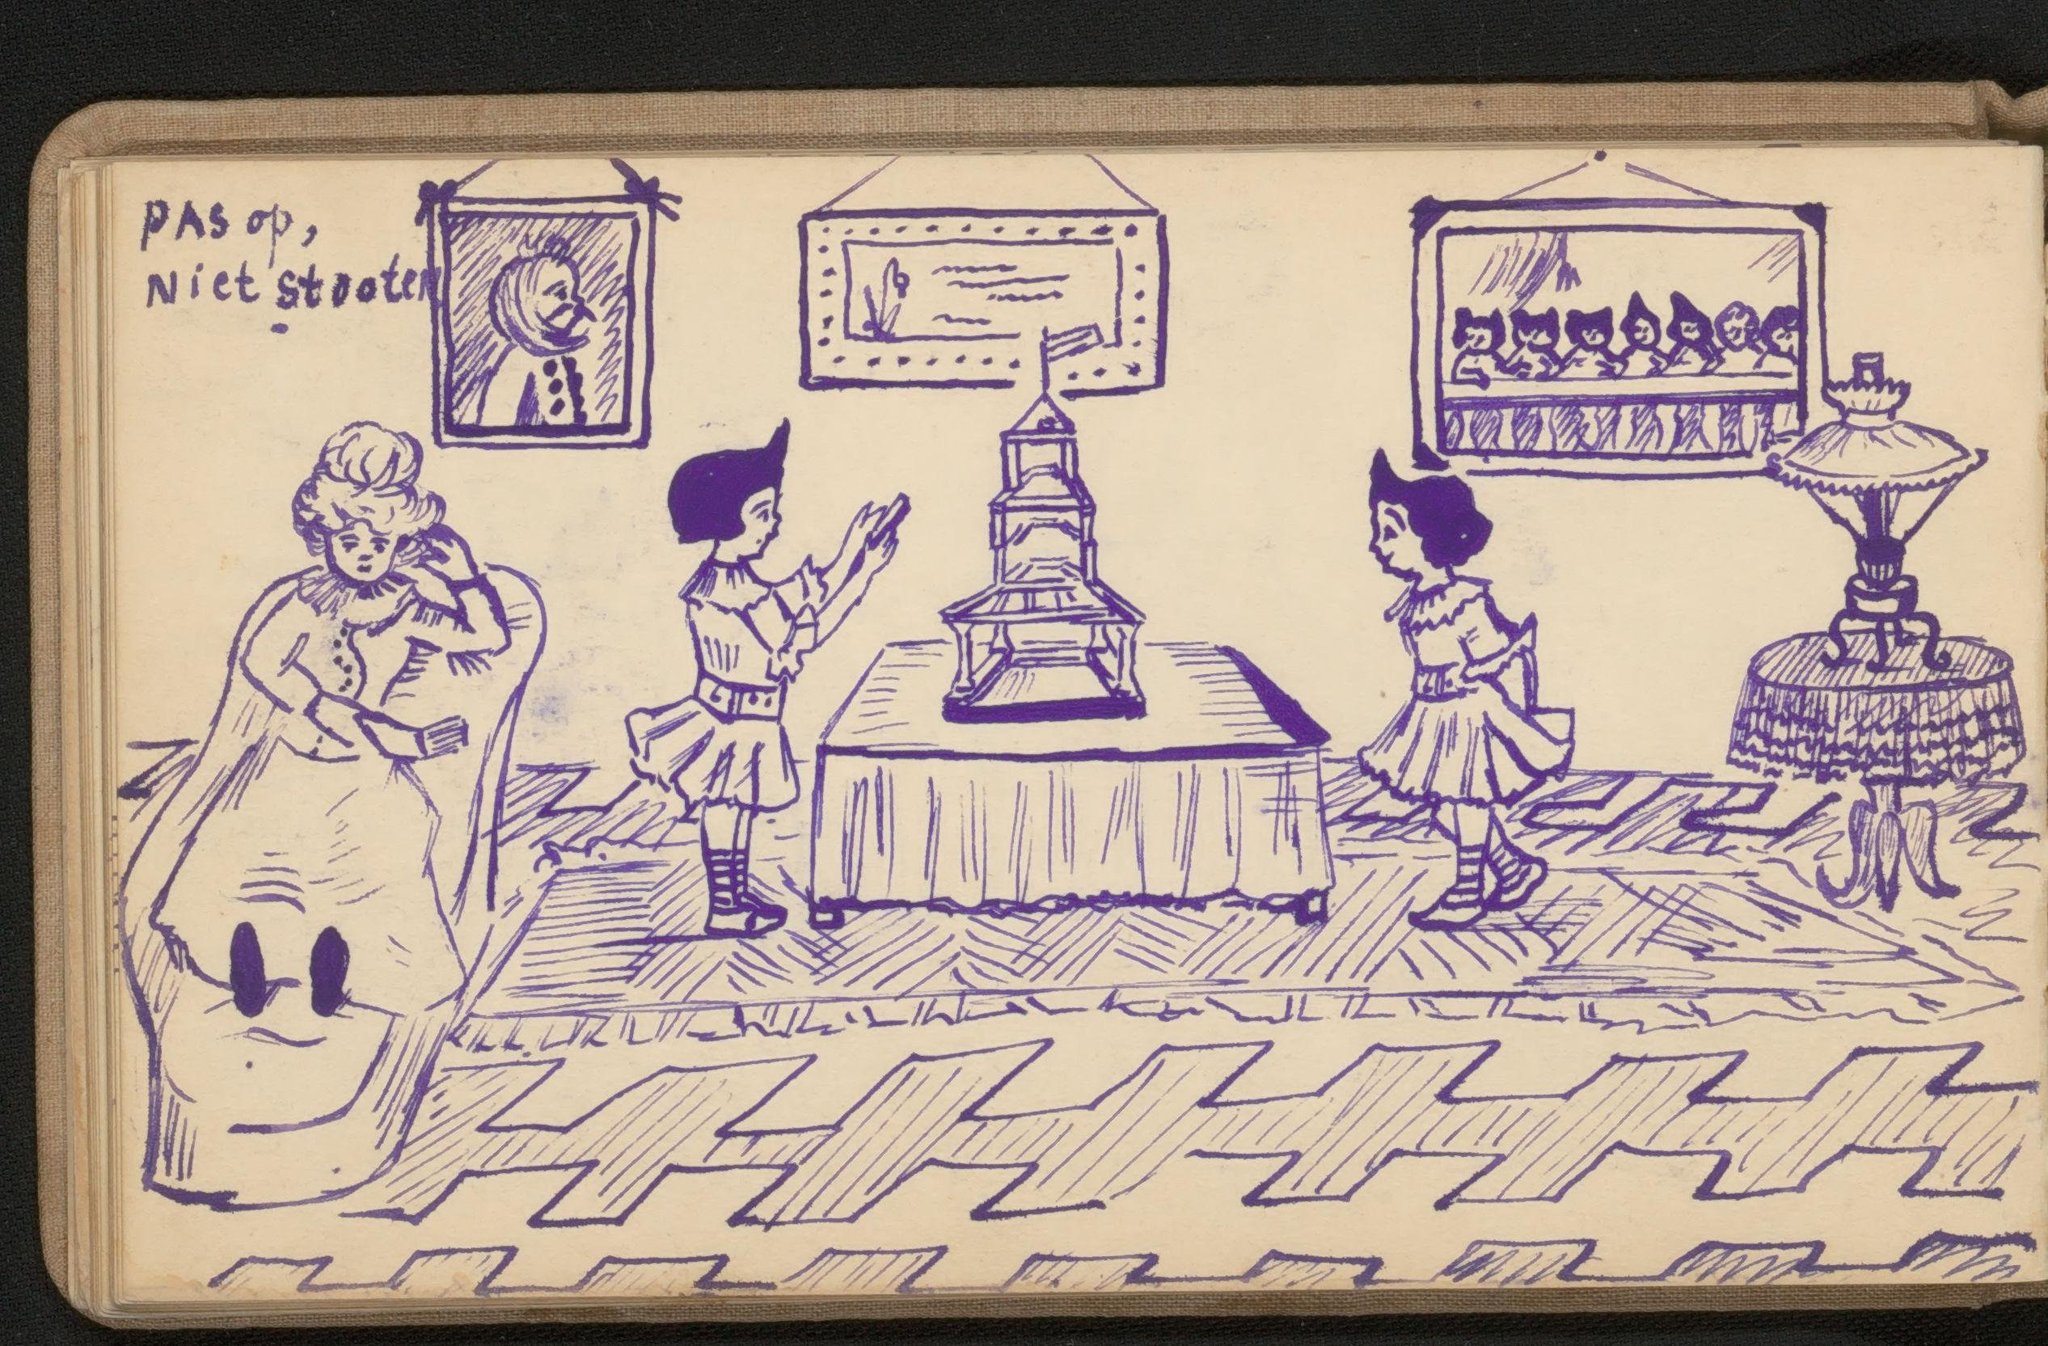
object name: sketchbook leaf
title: Pas op, niet stoten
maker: Anonymous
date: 1875-1920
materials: ink, paper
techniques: pen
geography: netherlands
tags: children's games and plays, building model houses, family life at home, living-room, parlour, sitting-room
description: Kinderen bouwen een huis van plankjes in de kamer. Onderdeel van het schetsboek met humoristische tekeningen over het leven van een 'famille nombreuse'. Onderwerpsrubrieken binnen de Atlas Zeden en Gewoonten: Zeden en Gewoonten in Engeren Zin, Des menschen beging, midden en einde, Kinderleven.